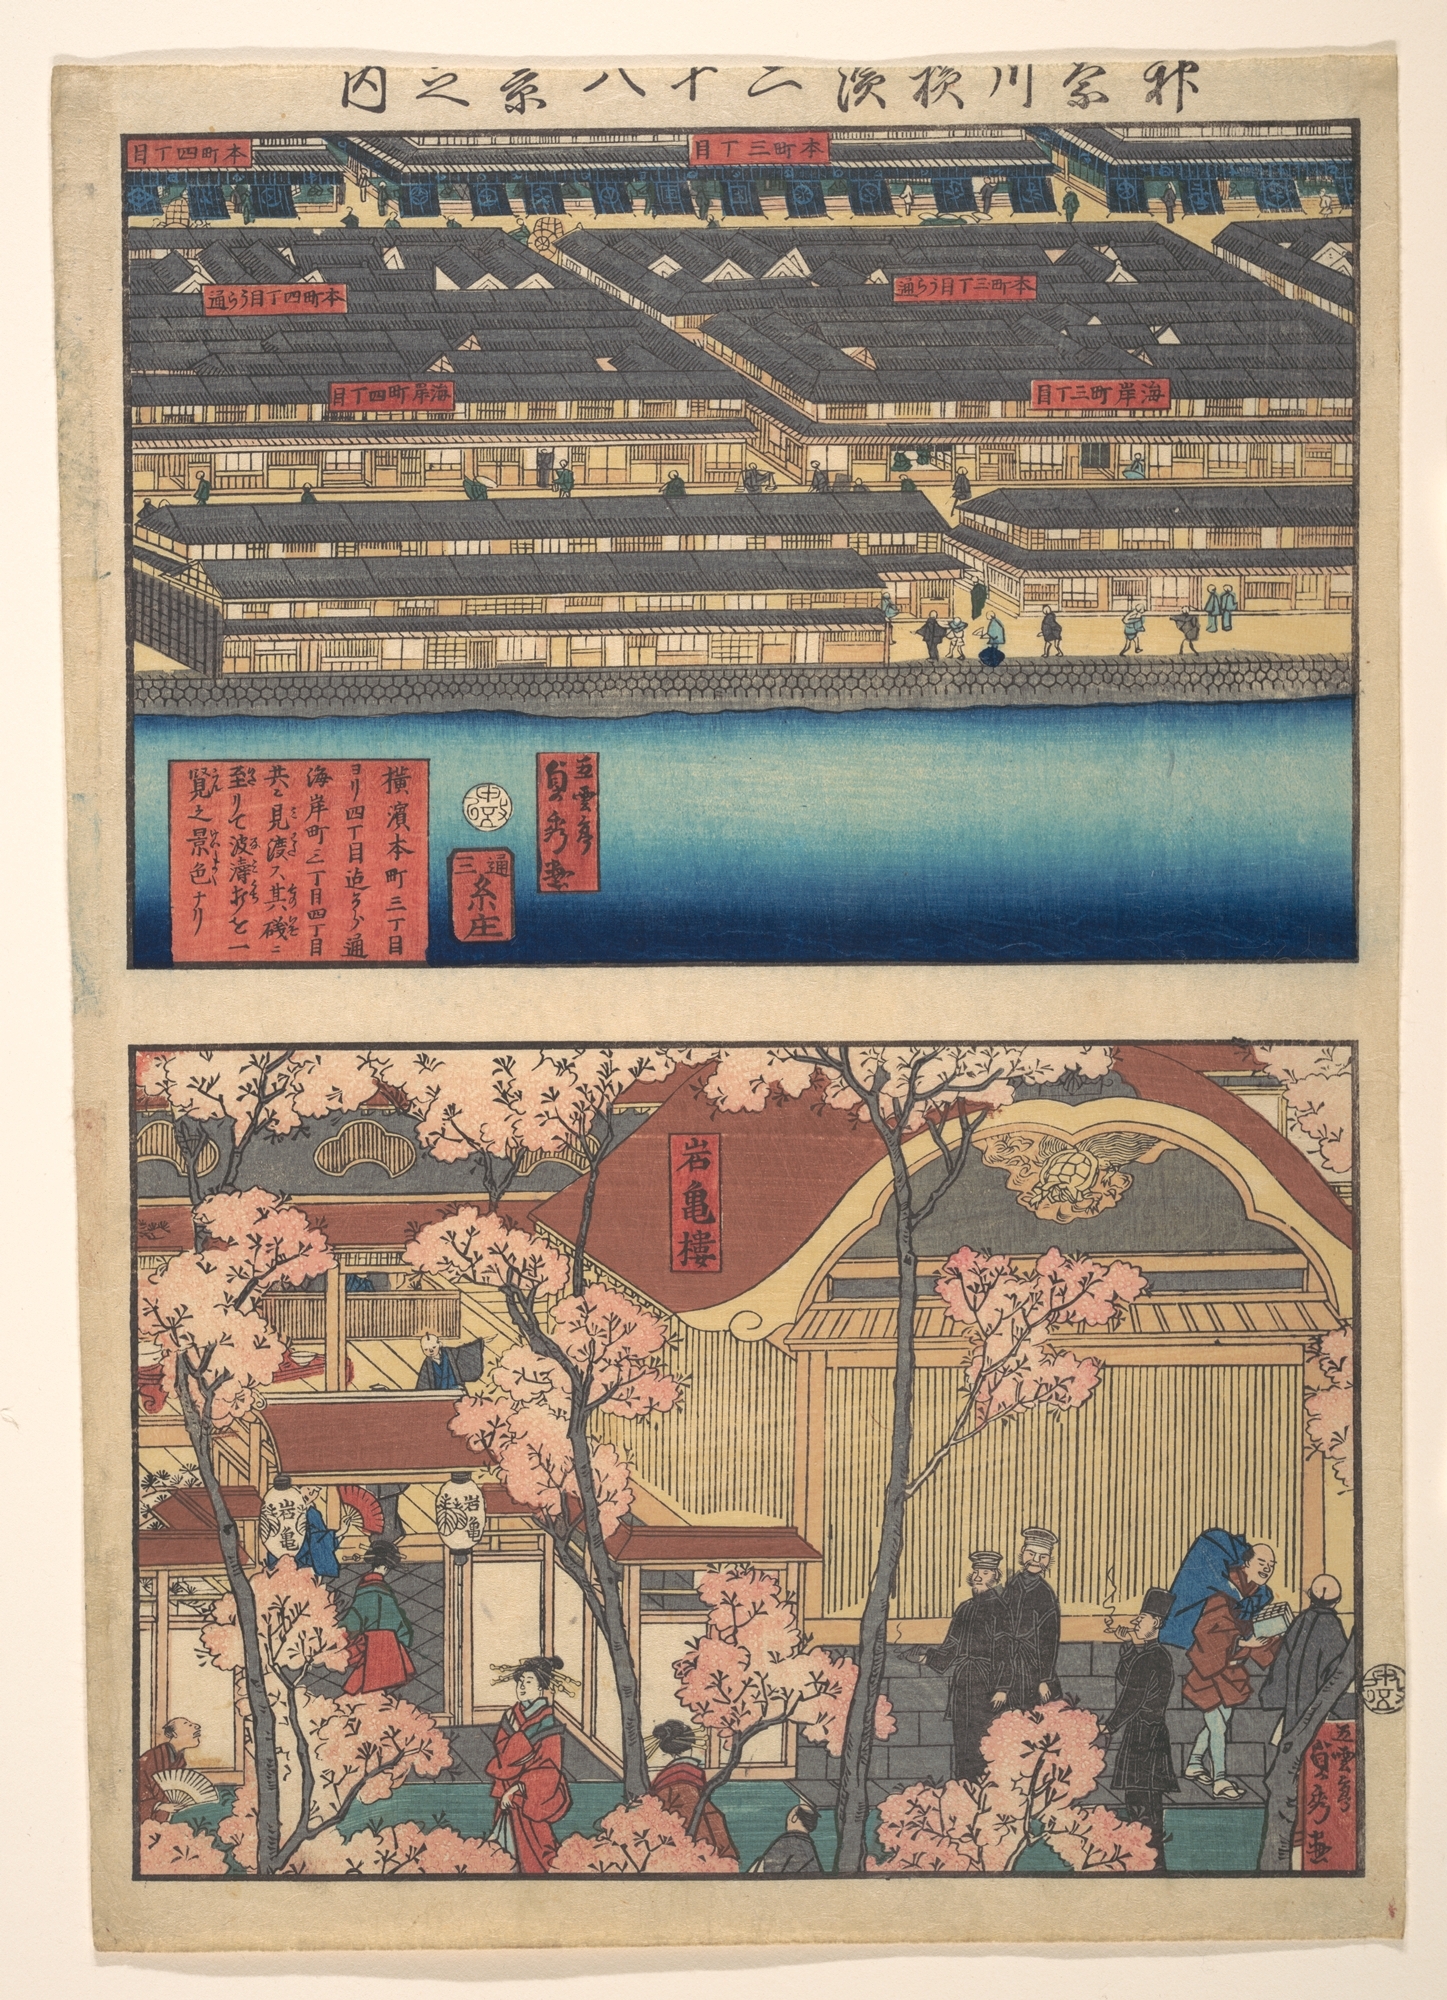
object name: print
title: Two Views: Waterfront at Kaigan-chō, 3-chome and 4-chome, and the Entrance to the Gankirō Tea House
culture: japanese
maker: utagawa (gountei) sadahide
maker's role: artist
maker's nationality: japanese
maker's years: 1807-1873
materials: ink, paper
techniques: woodblock print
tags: buildings,men,women,tea houses